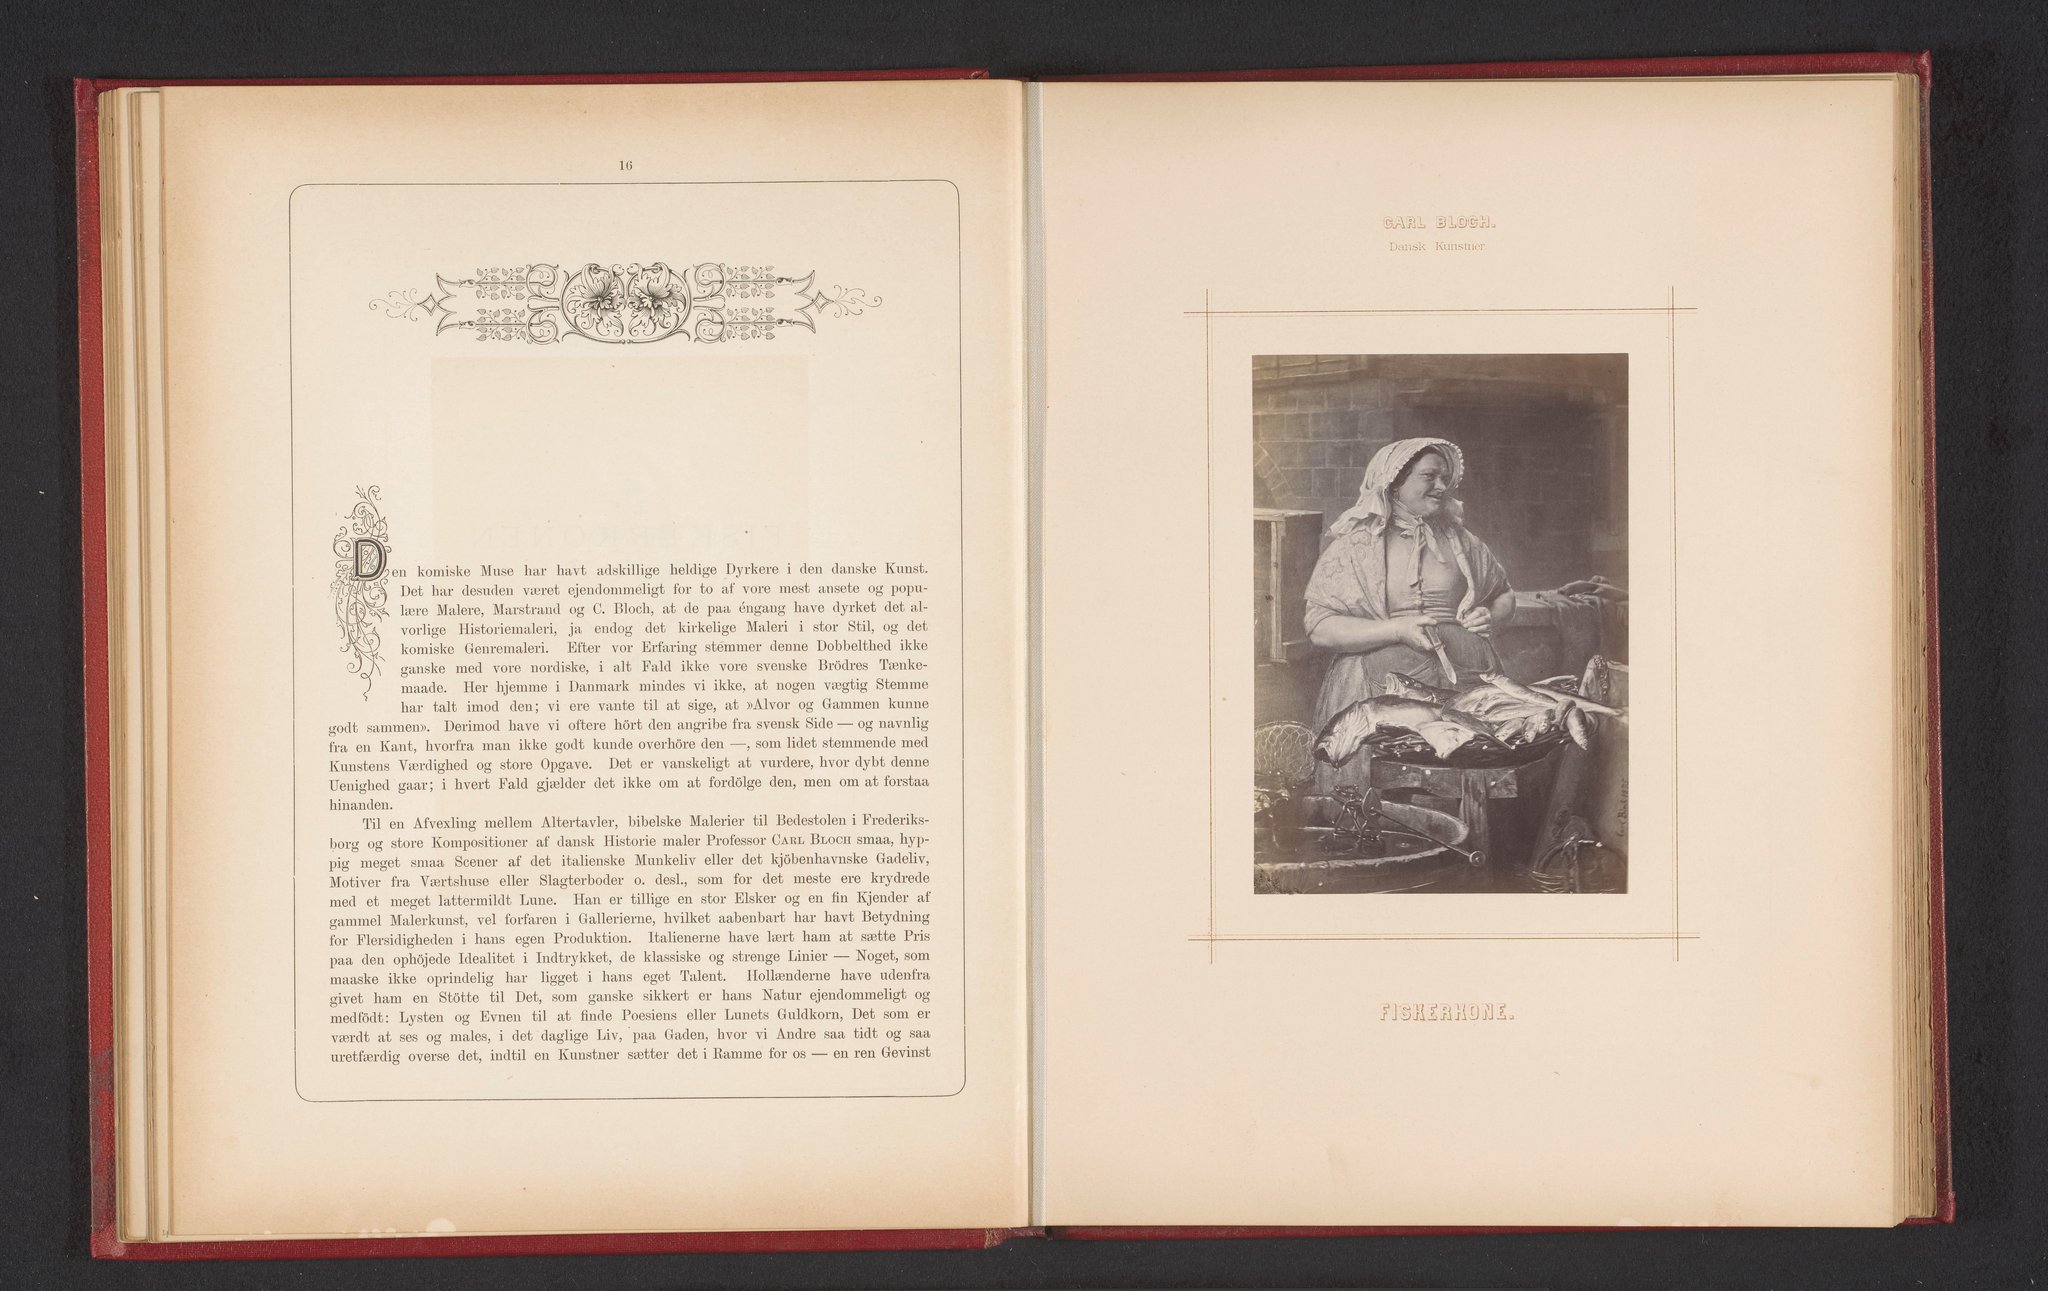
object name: page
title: Fotoreproductie van een schilderij van een vissersvrouw door Carl Bloch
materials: photographic support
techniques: albumen print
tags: merchant, salesman (with name of trade or profession) - bb - women engaged in trade and commerce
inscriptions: inscription: ‘Dansk Kunstner.’